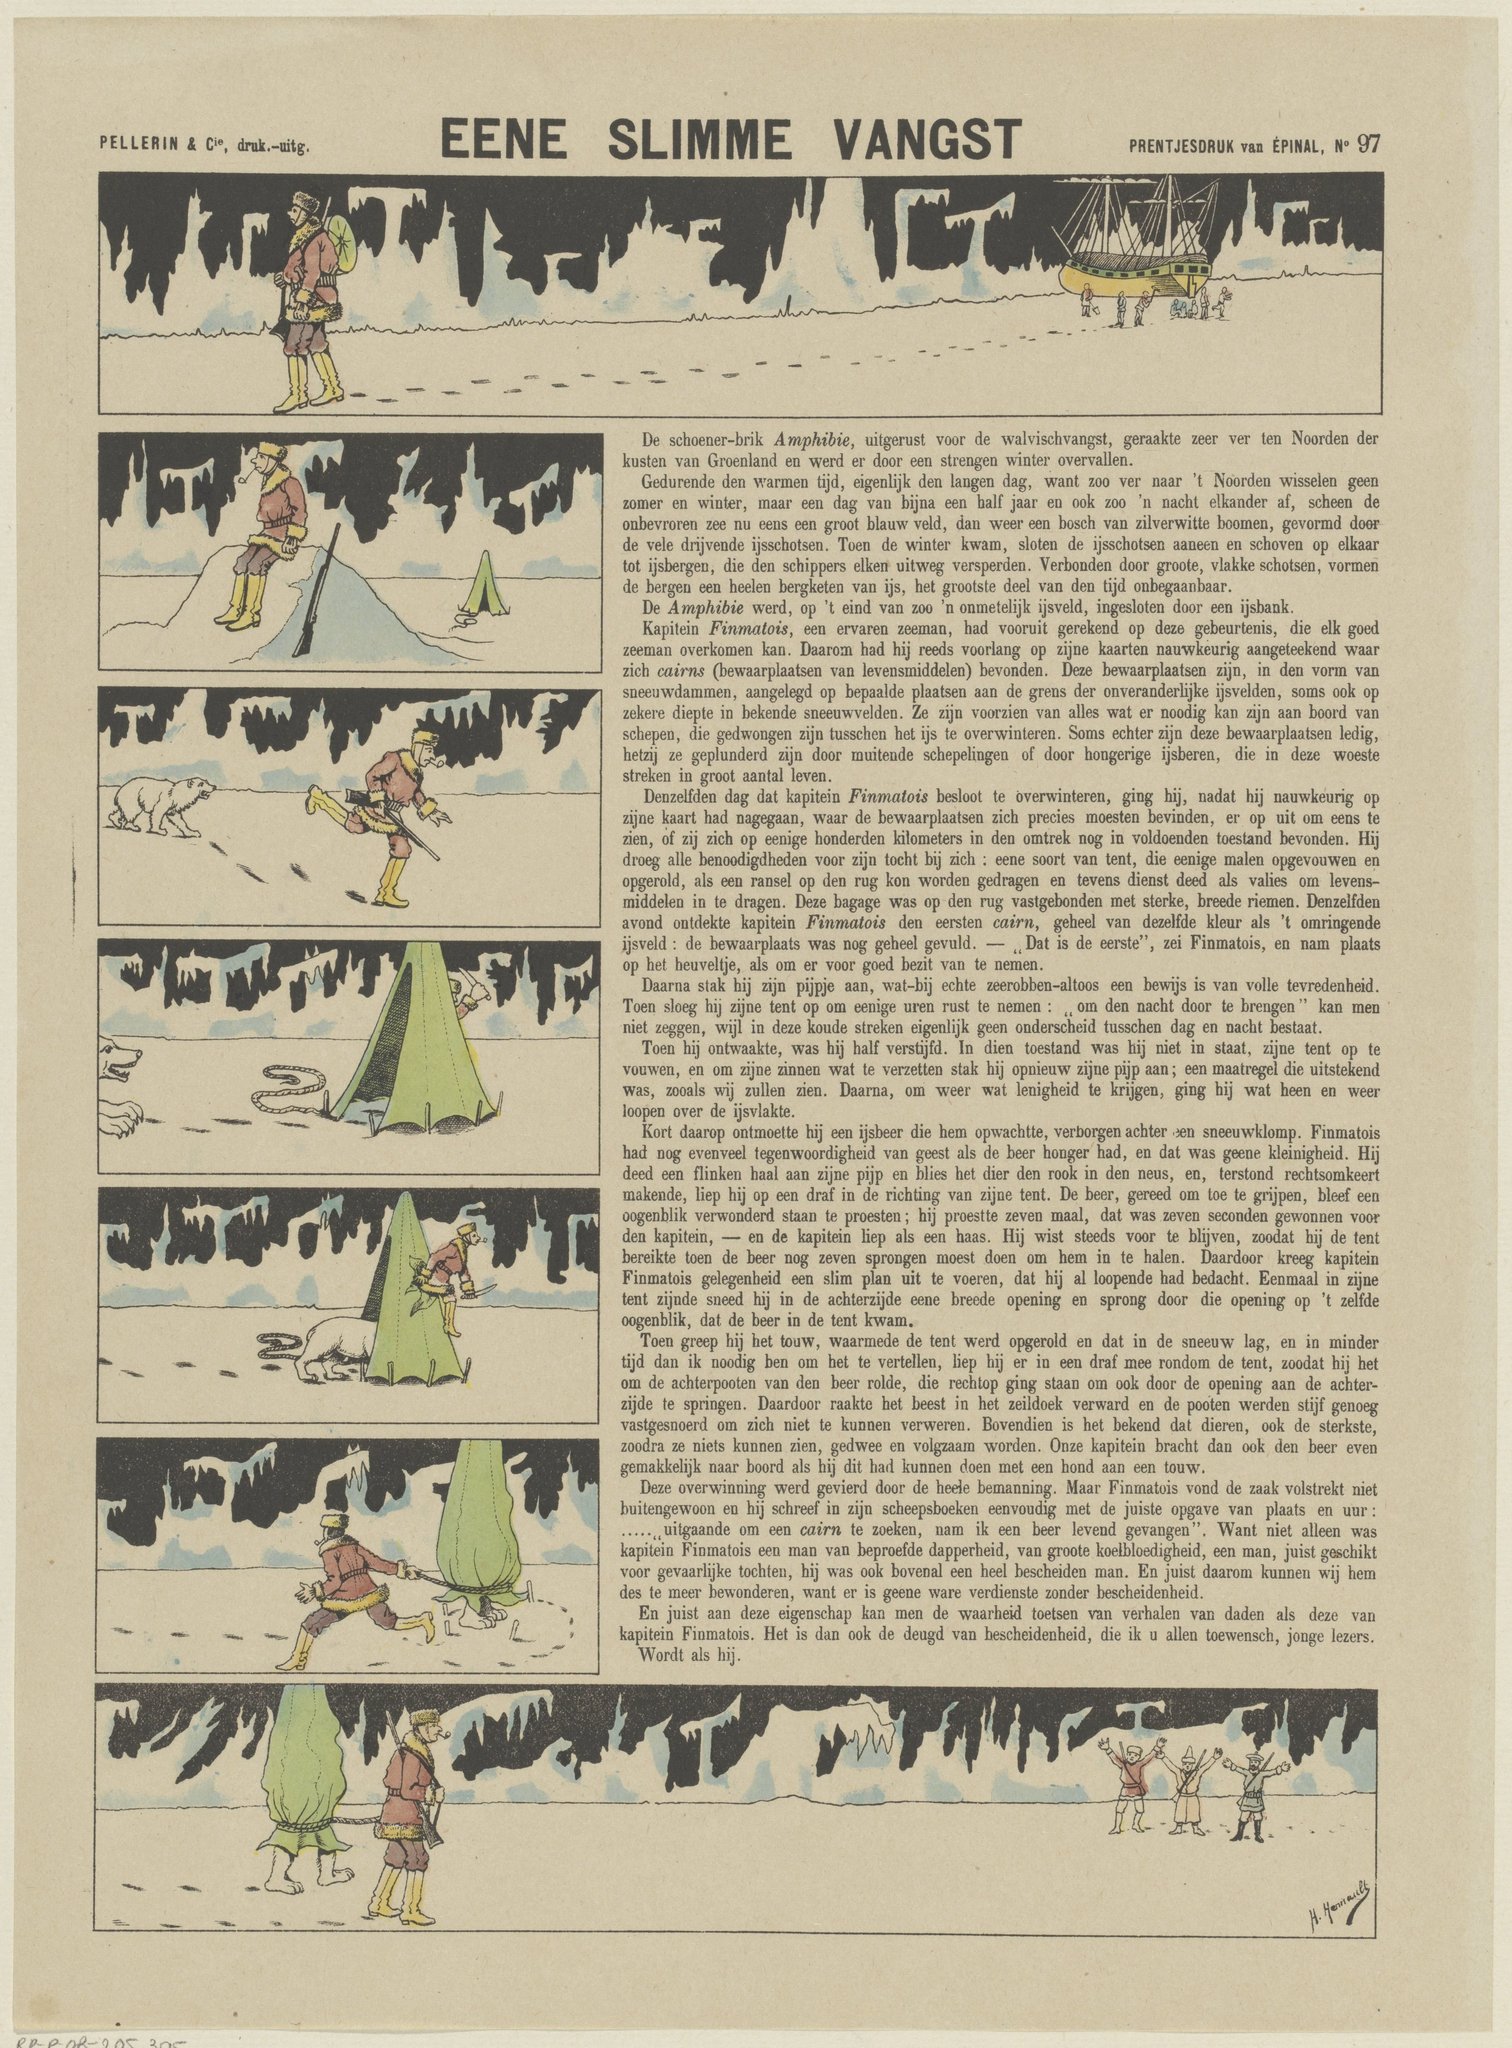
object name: popular print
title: Prentjesdruk van Epinal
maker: henry hennault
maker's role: print maker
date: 1902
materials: paper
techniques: colour, letterpress printing, lithograph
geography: epinal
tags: beasts of prey, predatory animals: polar bear, tent, catching animals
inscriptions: collector's mark: Lugt 2760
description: Blad met 7 voorstellingen van een man die een ijsbeer vangt in zijn tent. Rechts een bijschrift. Genummerd rechtsboven: No 97.